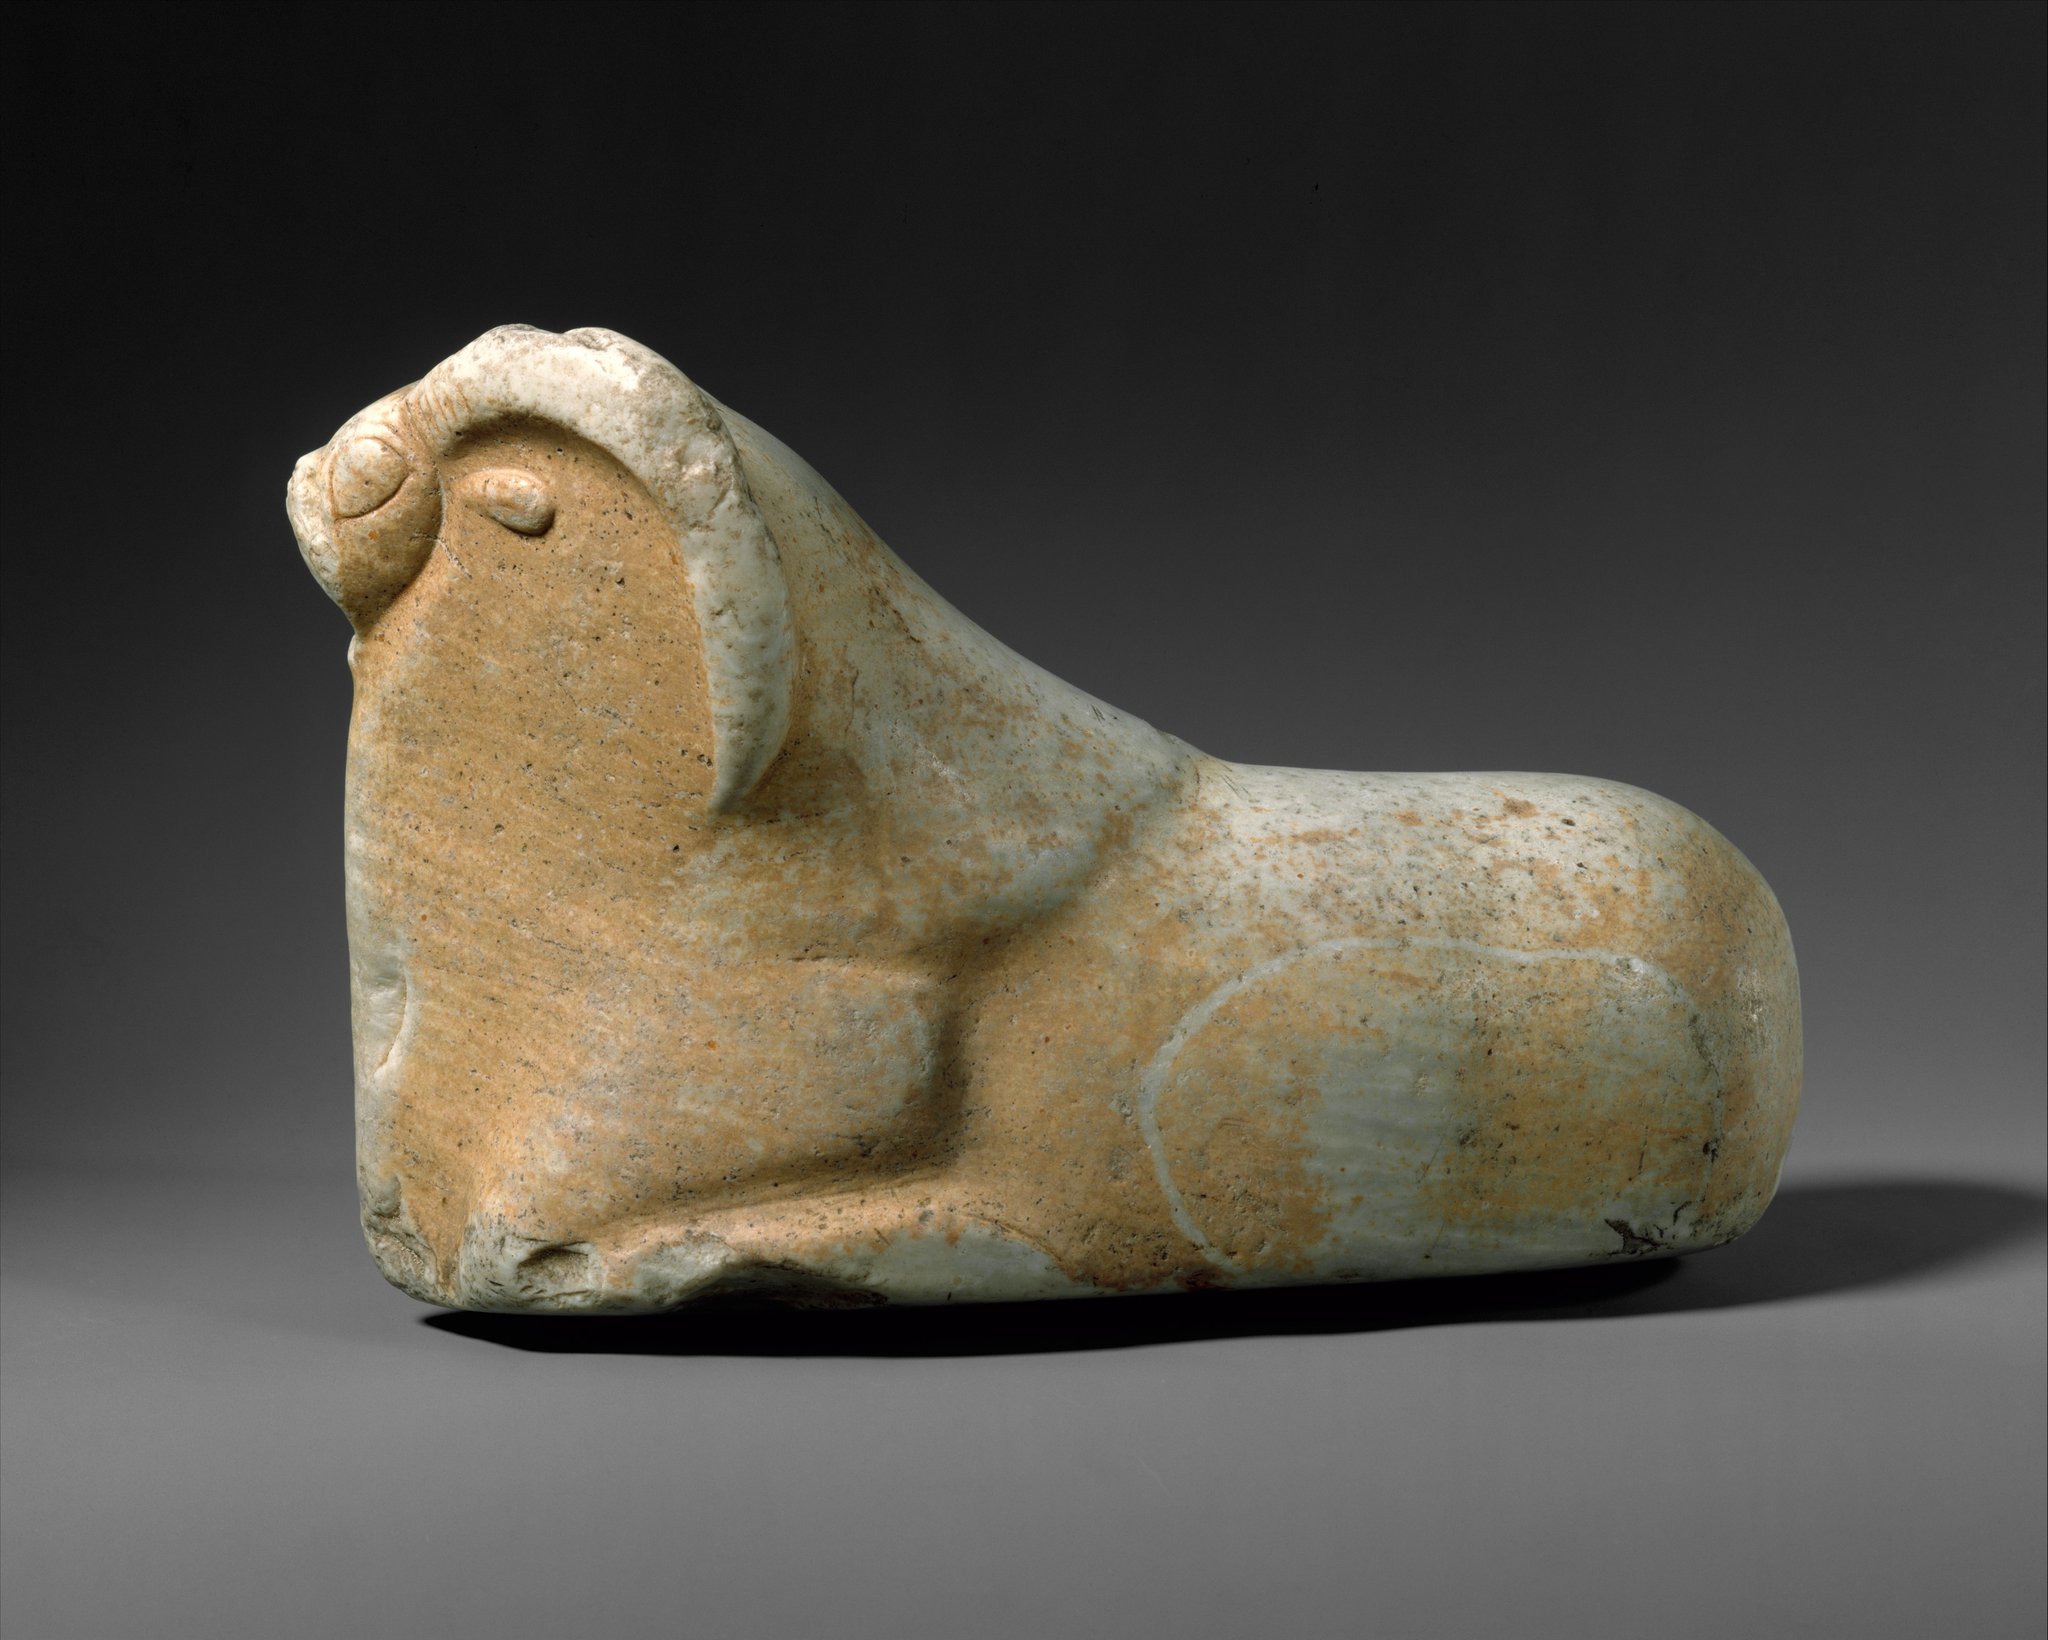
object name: sculpture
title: Reclining mouflon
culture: indus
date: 2600-1900 BCE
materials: marble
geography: indus valley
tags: animals